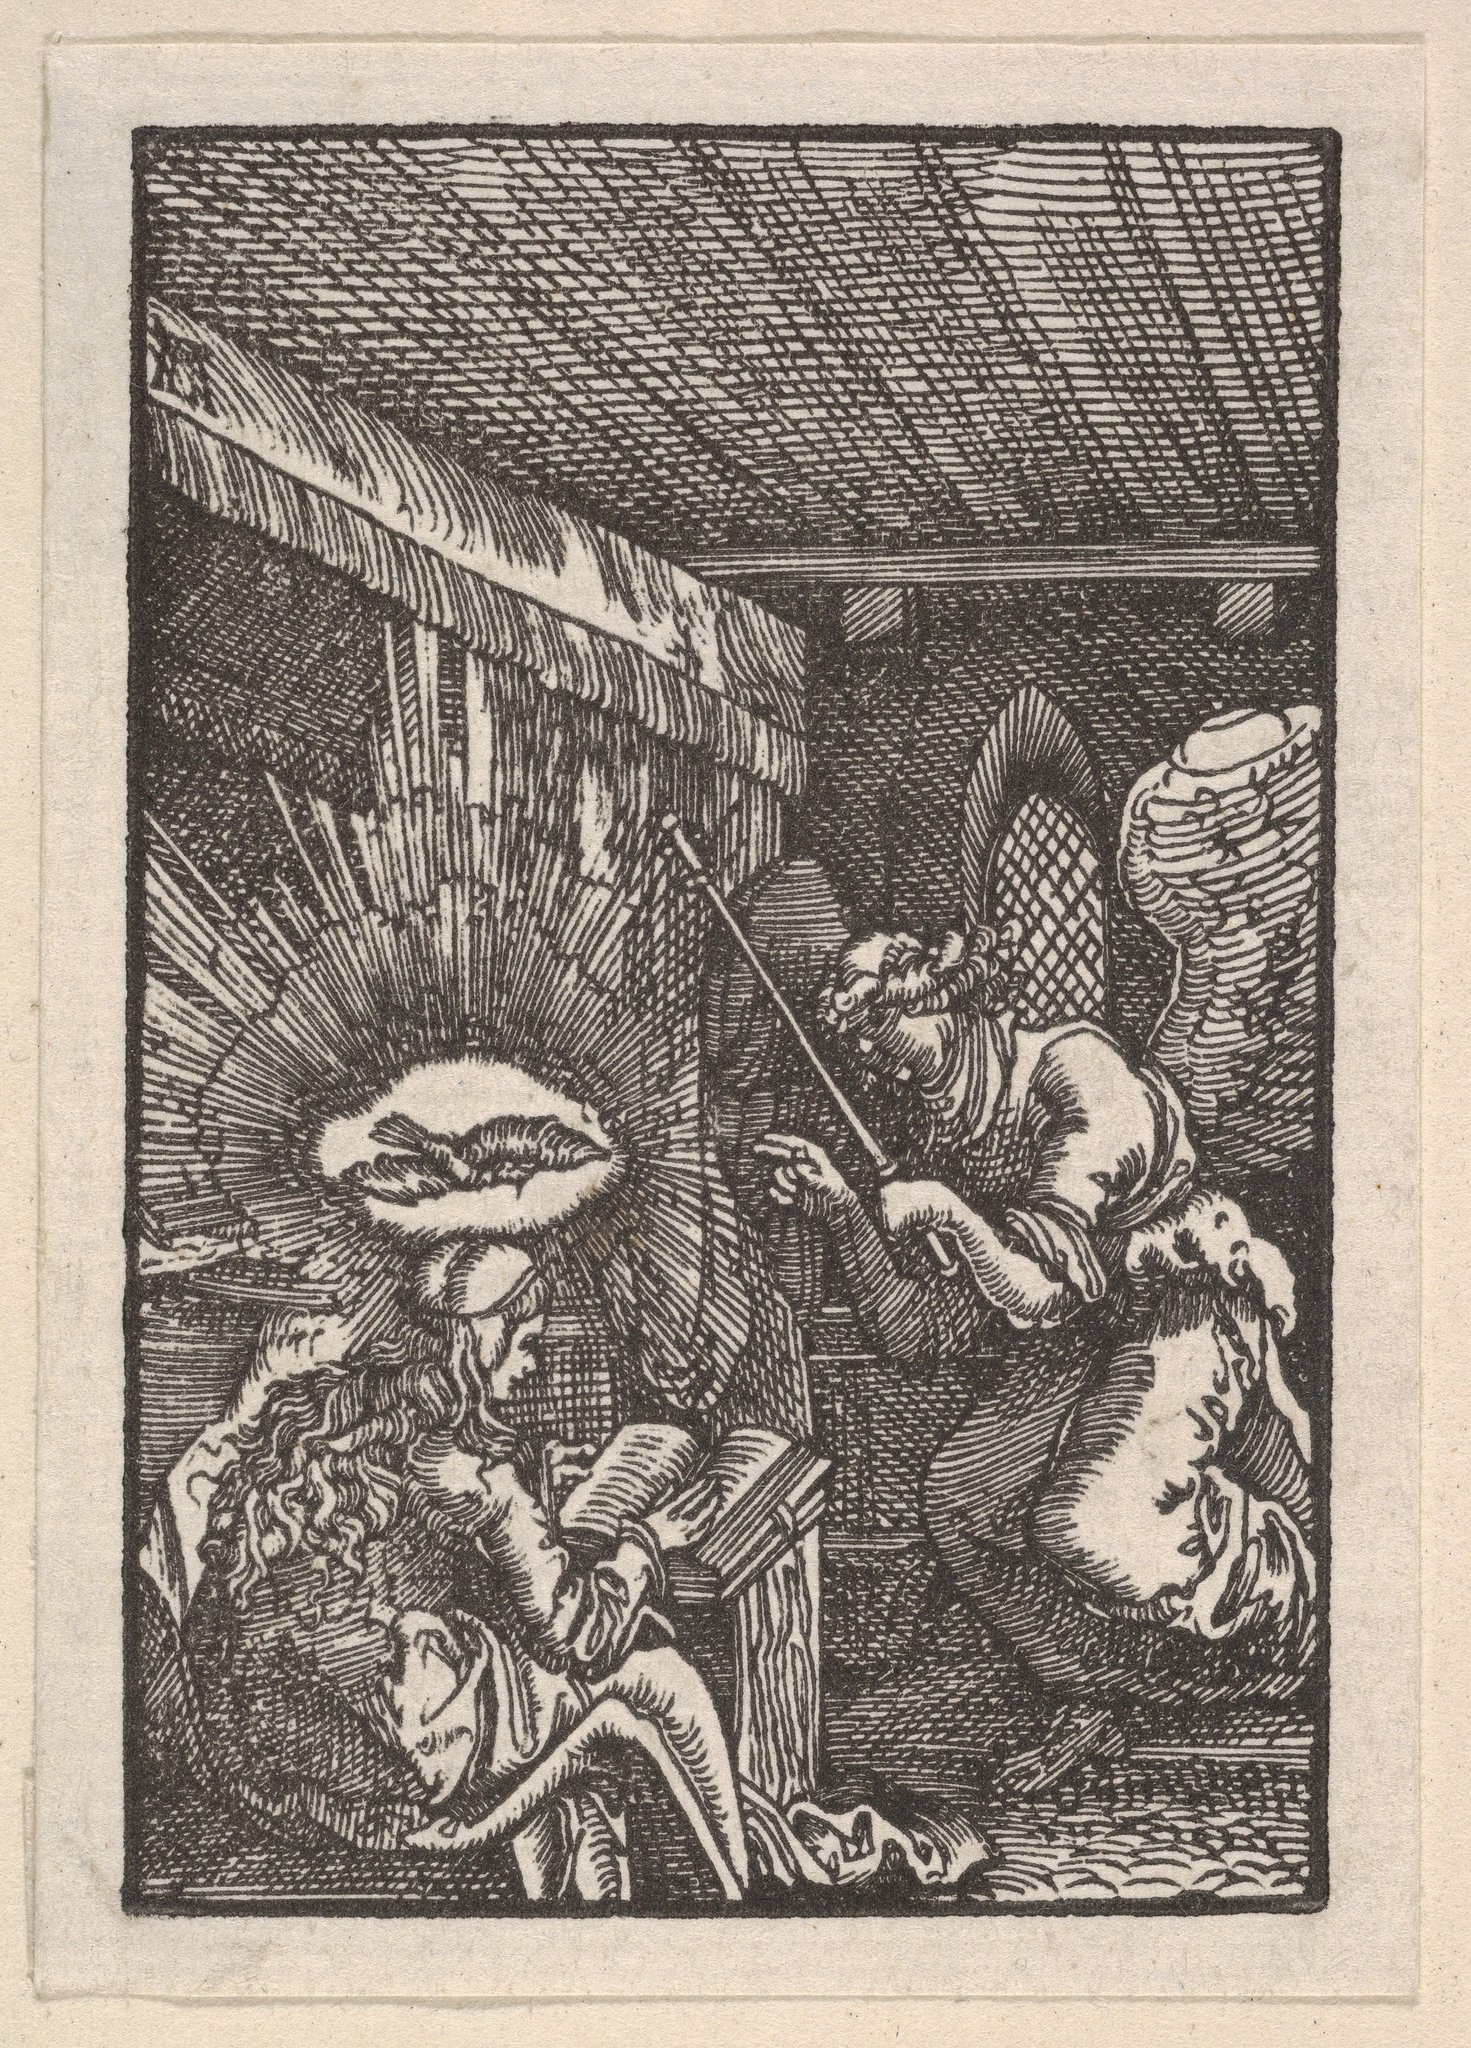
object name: print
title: Annunciation, from "The Fall and Salvation of Mankind Through the Life and Passion of Christ"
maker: albrecht altdorfer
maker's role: artist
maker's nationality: german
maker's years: 1480-1538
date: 1500-1538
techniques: woodcut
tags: angels,virgin mary,annunciation